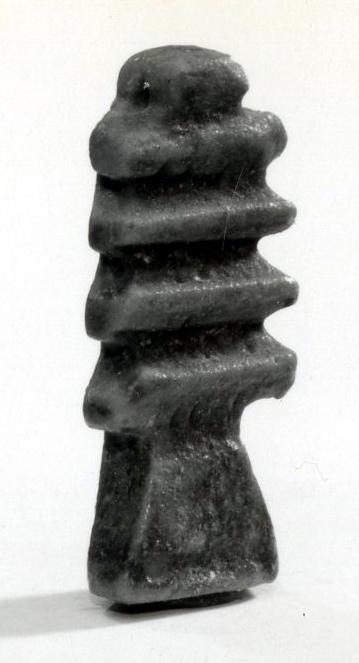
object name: amulet, djed pillar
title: Djed pillar Amulet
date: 664-332 BCE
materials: faience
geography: egypt